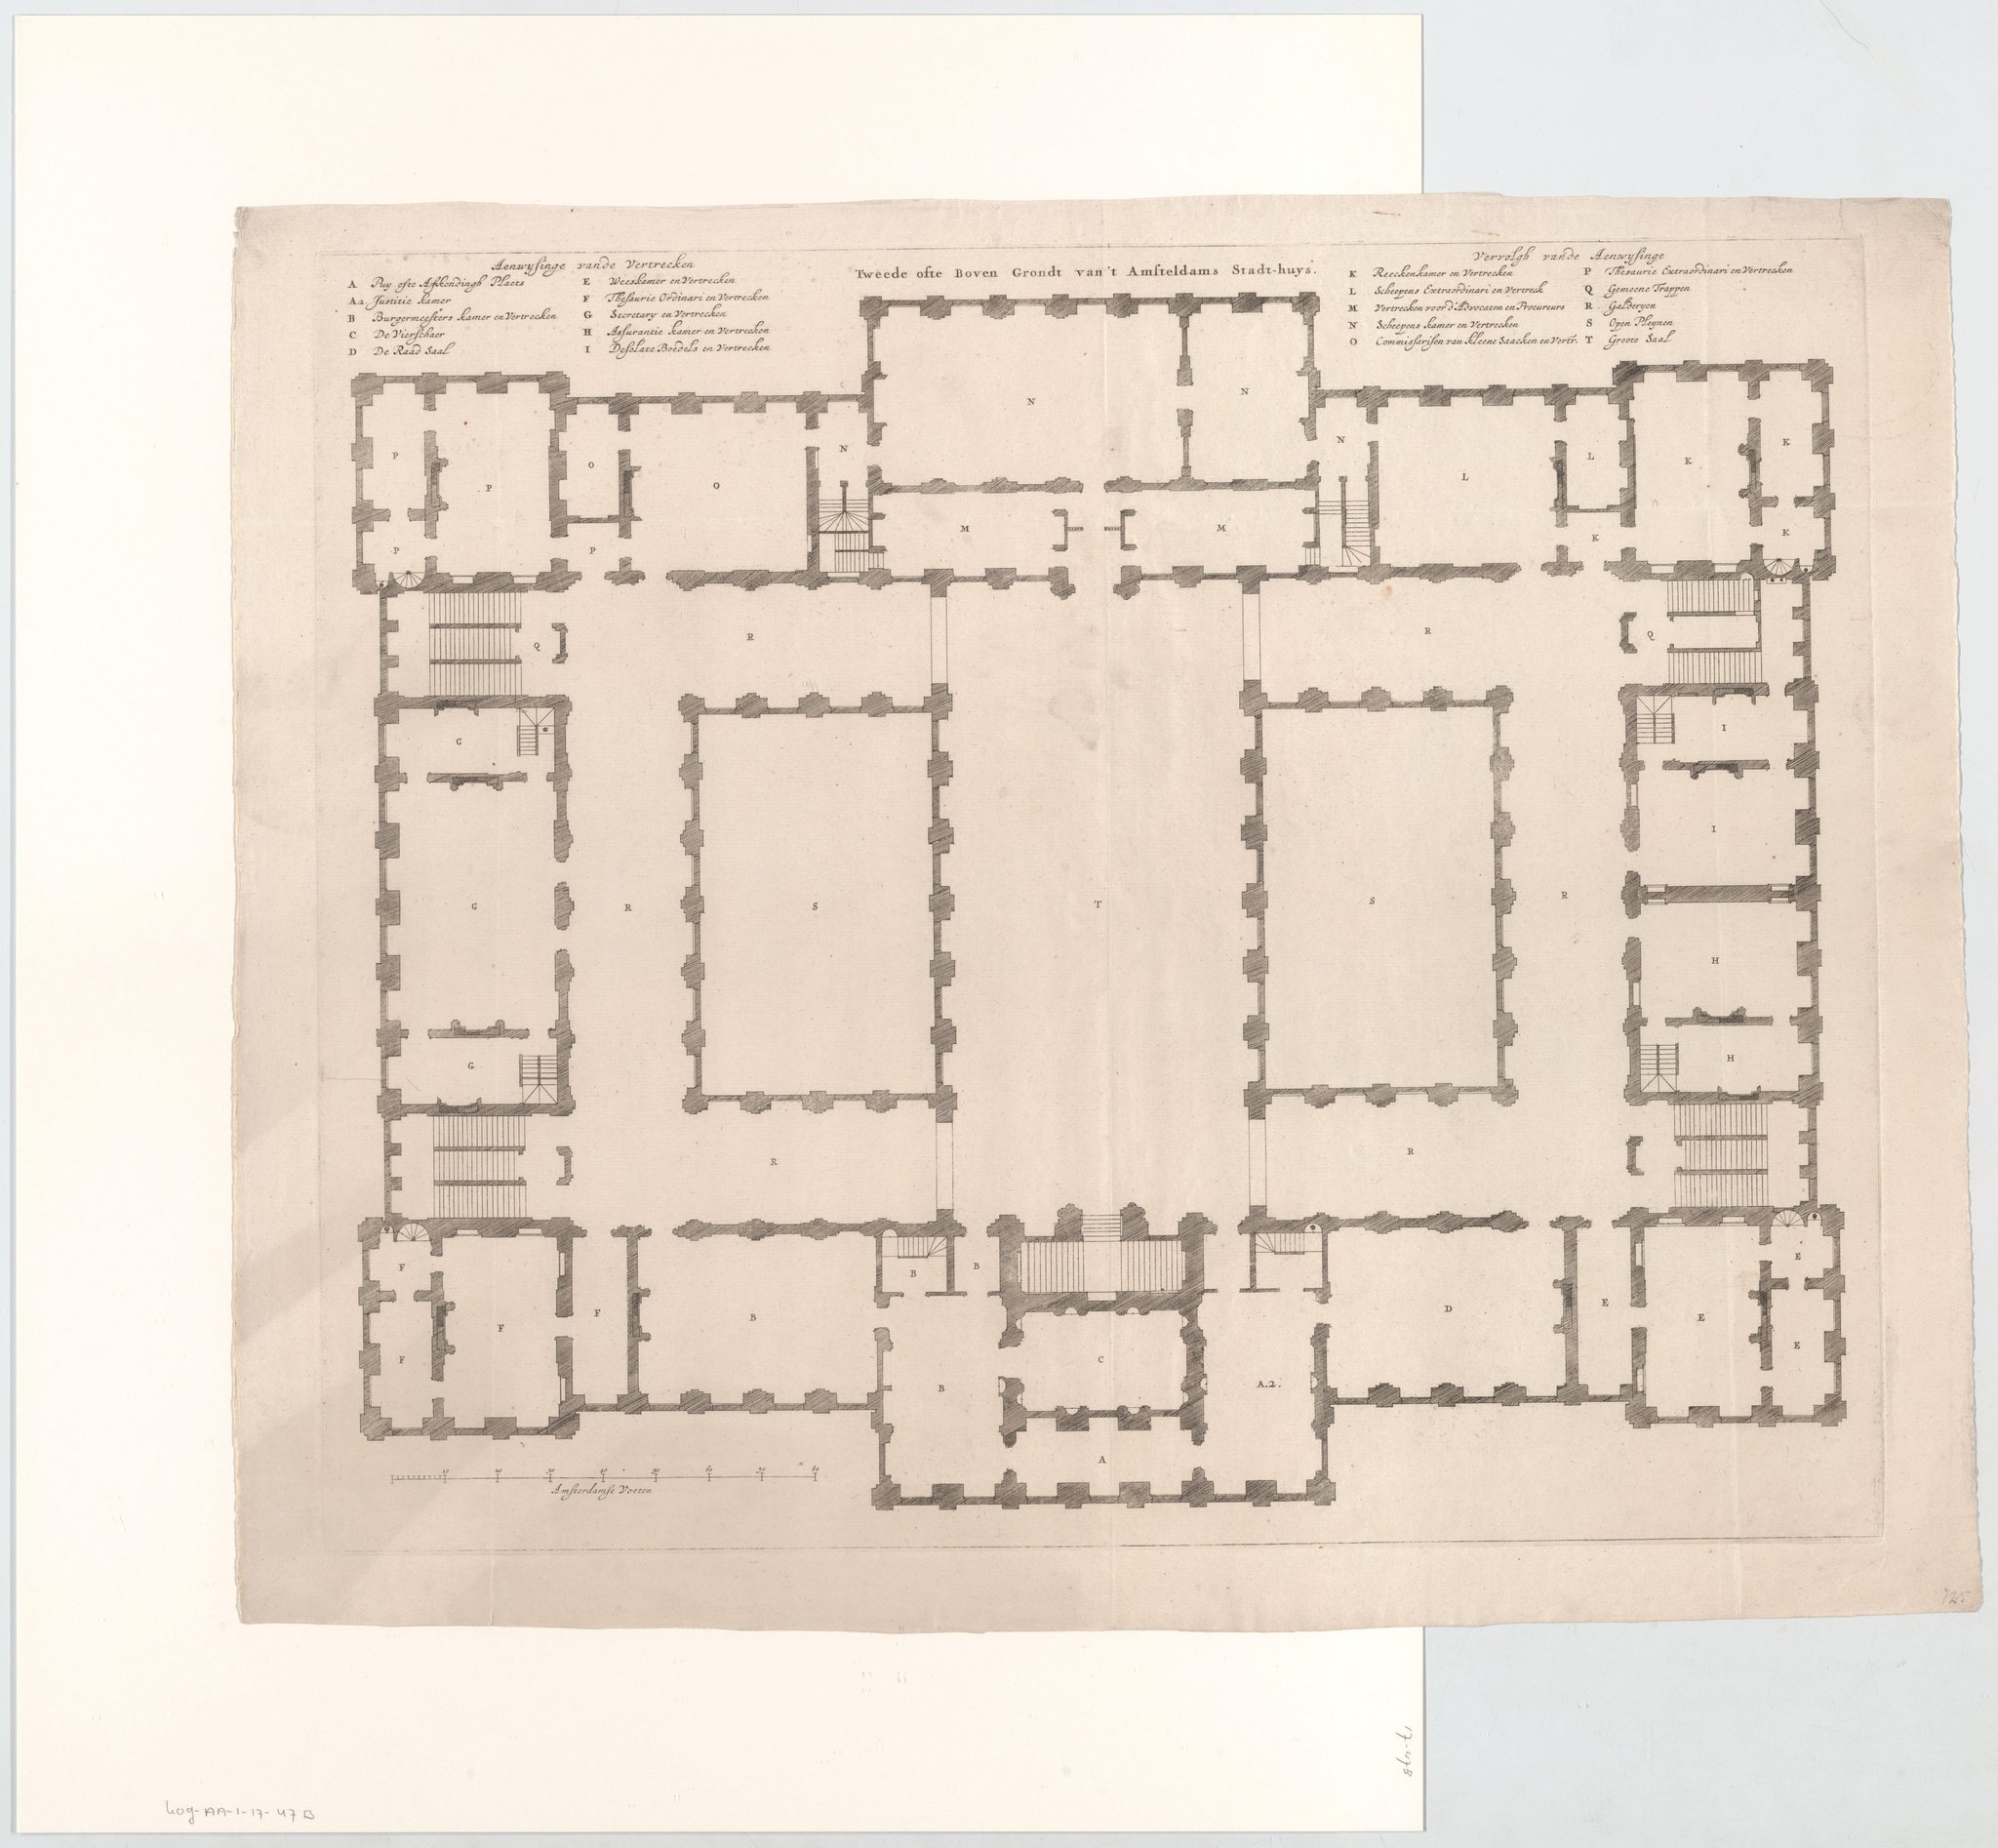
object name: print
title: Plattegrond van de eerste verdieping (Tweede/Boven Grondt) van het Stadhuis op de Dam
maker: Anonymous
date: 1721-1774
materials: paper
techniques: etching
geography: amsterdam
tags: townhall, plan ~ architecture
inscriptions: inscription: ‘Legaat Joh. M. Coffeng / 1966’, collector's mark: ‘17B / 47’ Lugt 1641b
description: Onderwerpsrubriek binnen de Atlas Amsterdam: Nieuwe Stadhuis, van binnen: Beeldhouw- en Schilderwerk.